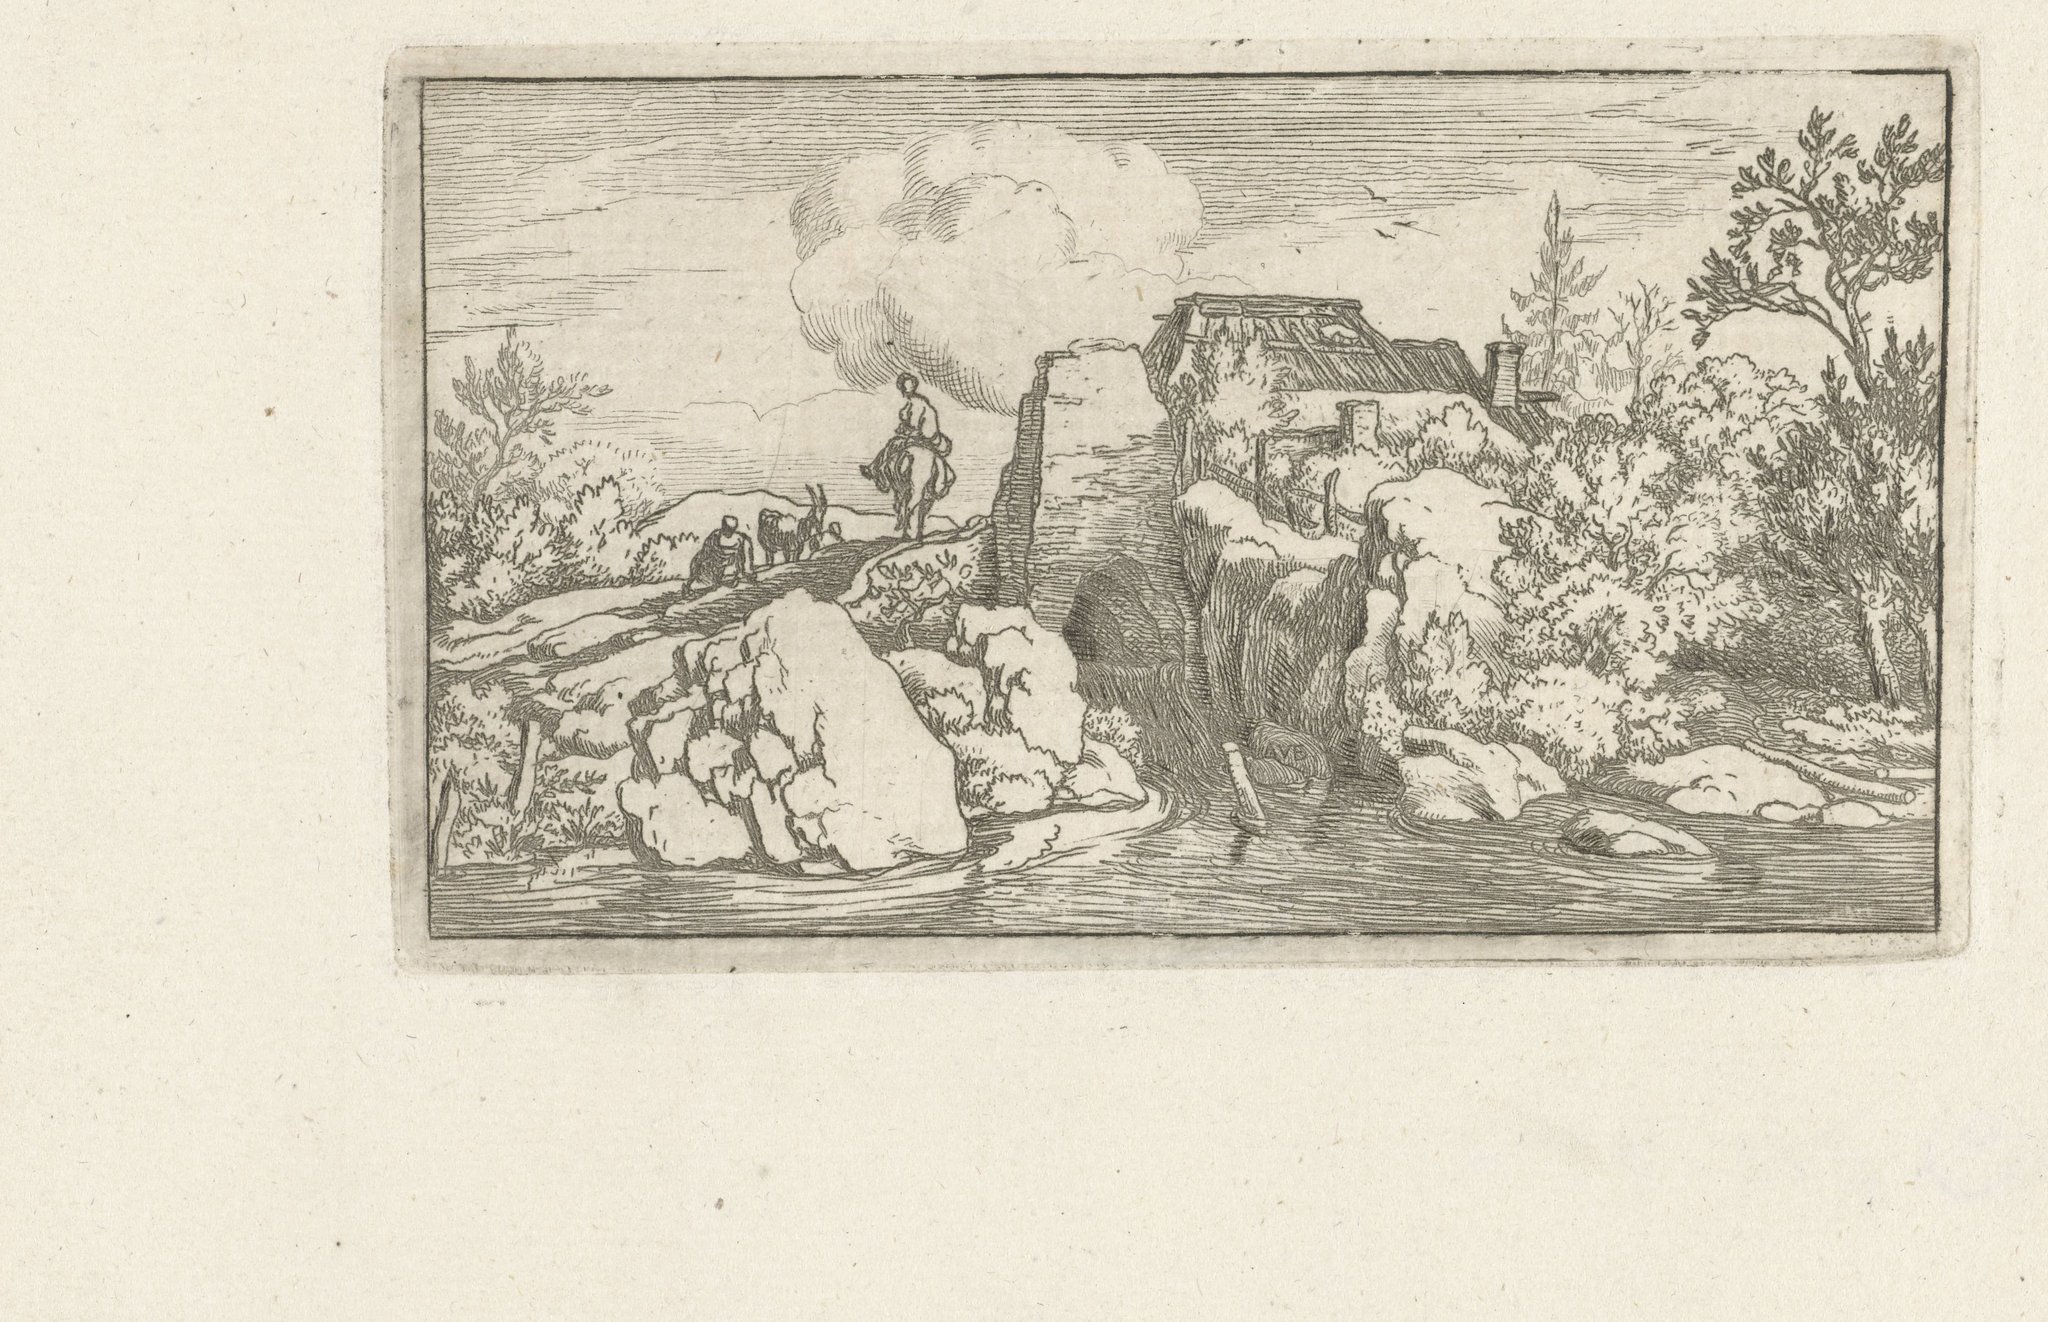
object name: print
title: De persoon te paard op den steenen brug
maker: allaert van everdingen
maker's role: draughtsman, painter, print maker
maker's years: 1621-1675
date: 1631-1675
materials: paper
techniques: etching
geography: netherlands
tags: landscape with bridge, viaduct or aqueduct - ii - ideal landscapes (+ city(-scape) with figures, staffage)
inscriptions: collector's mark: Lugt 2228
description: Landschap met waterpartij op de voorgrond. Op het pad over de rivier staat een bok en een persoon op een paard. Aan de overkant van de brug zijn enkele daken zichtbaar.